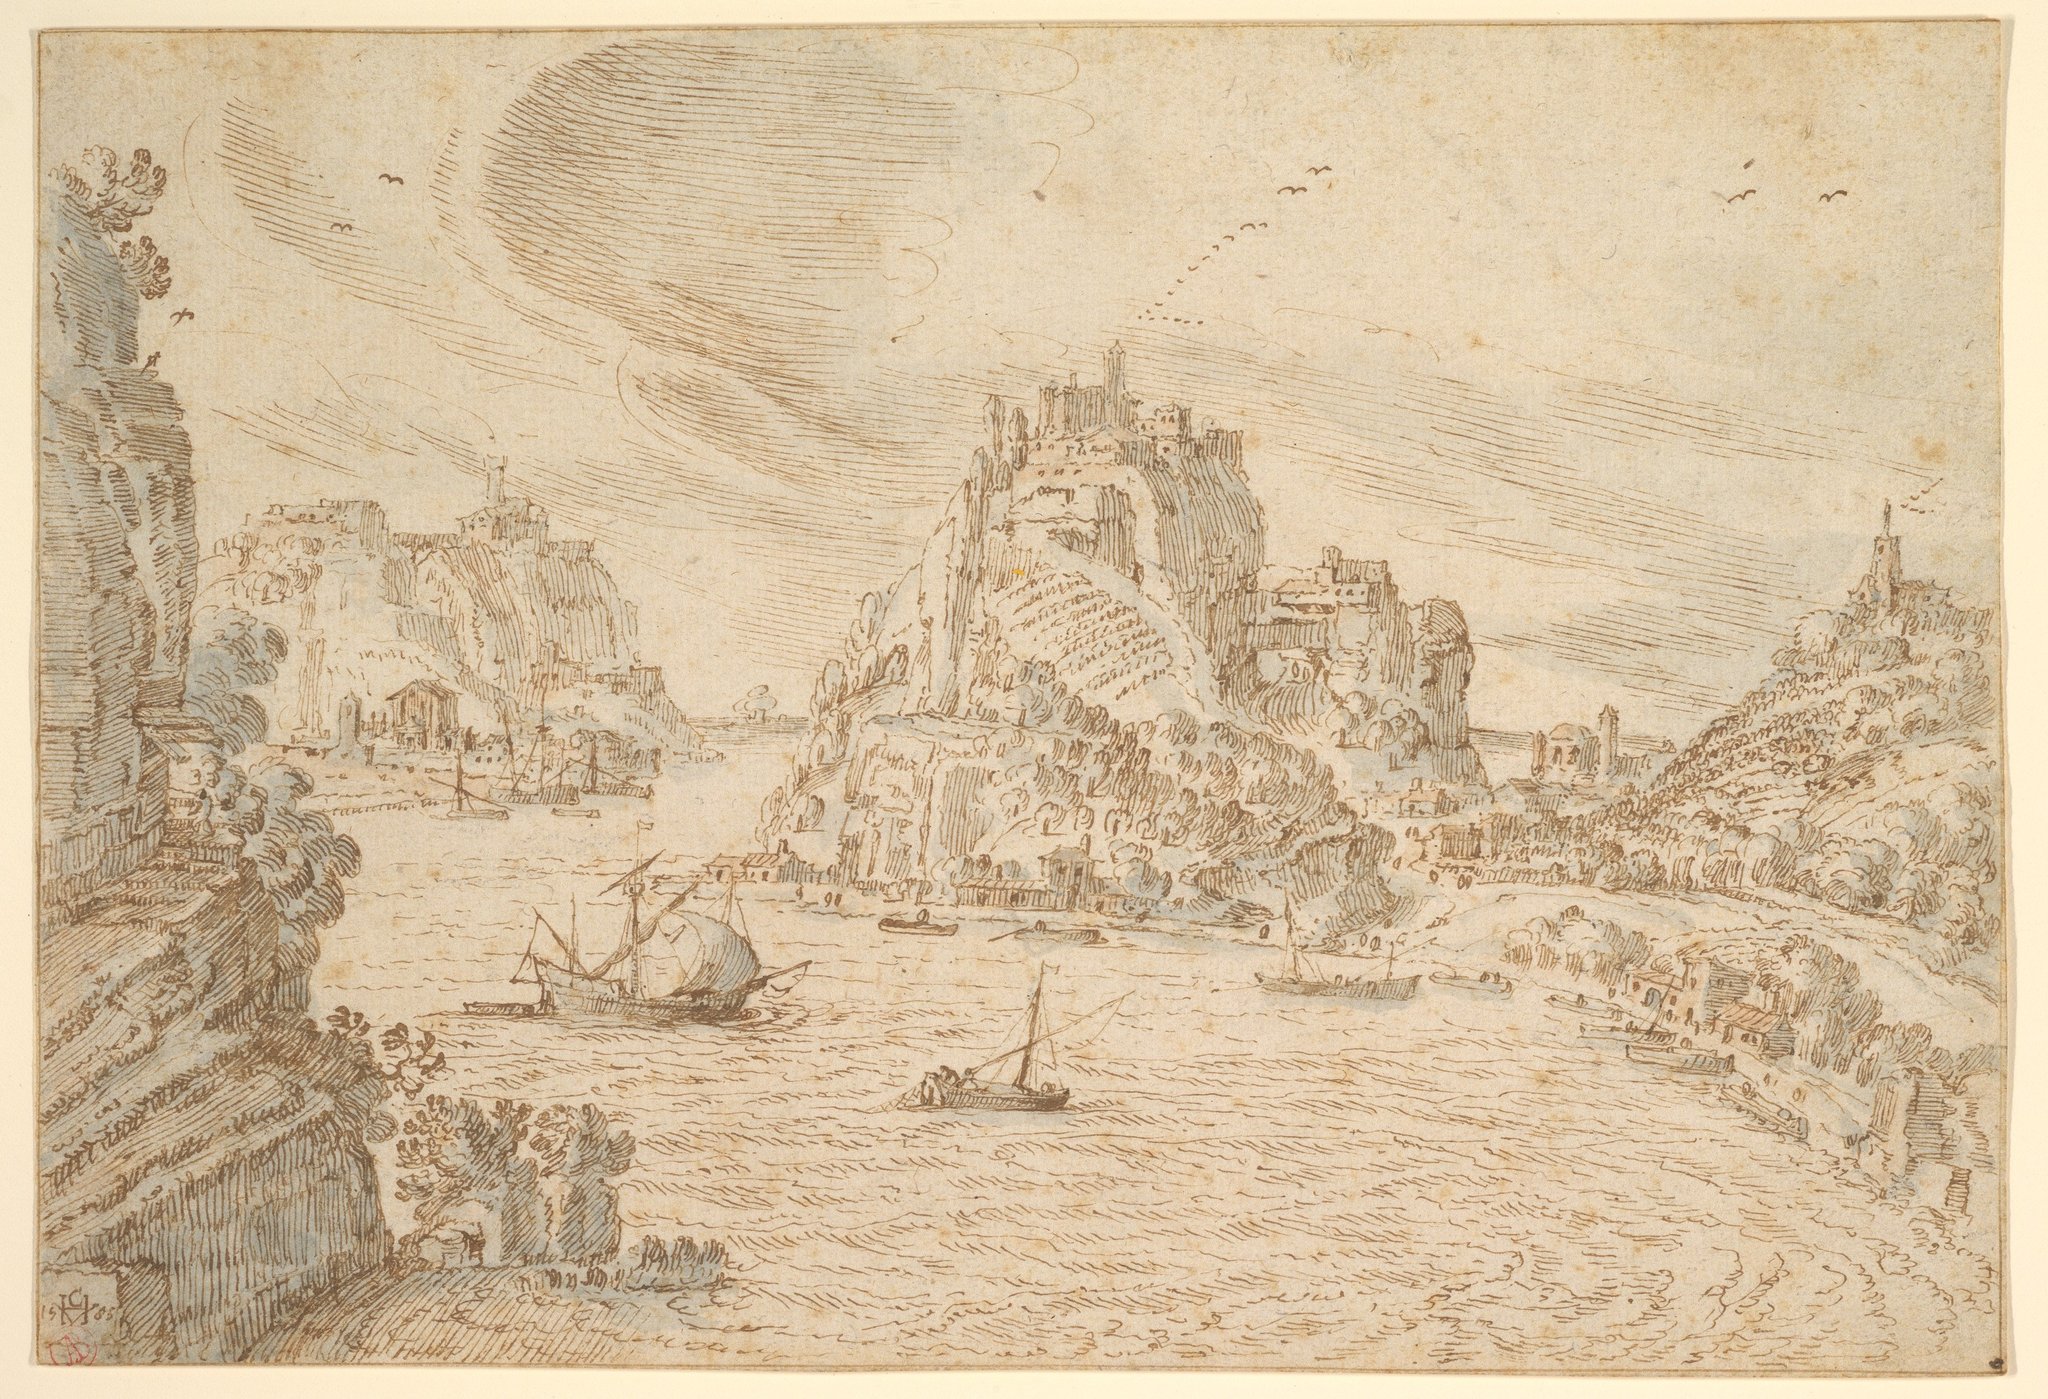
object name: drawing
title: A Rocky Estuary with Ships and Hill Towns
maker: hendrik van cleve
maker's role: artist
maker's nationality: netherlandish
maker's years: 1525-1589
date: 1585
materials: ink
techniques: pen, wash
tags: towns,ships